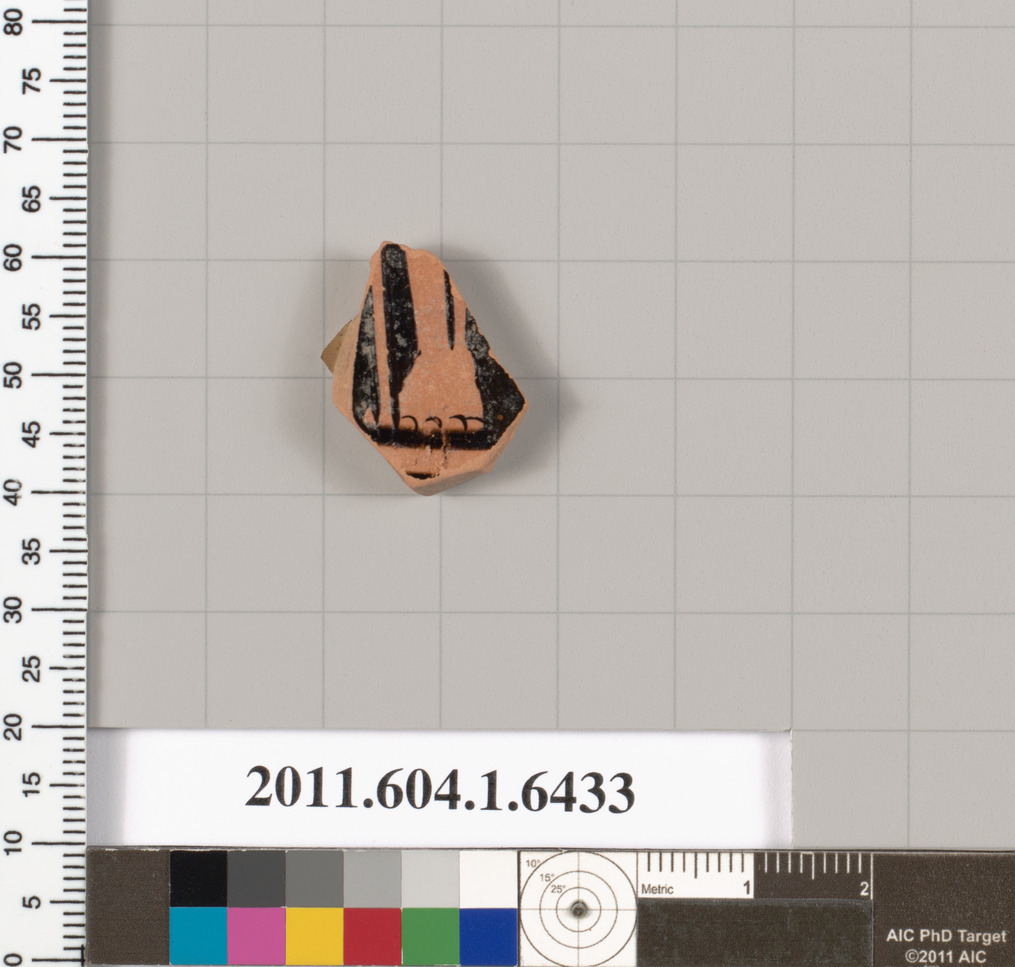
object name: kylix fragment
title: Terracotta fragment of a kylix (drinking cup)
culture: greek, attic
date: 490-480 BCE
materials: terracotta